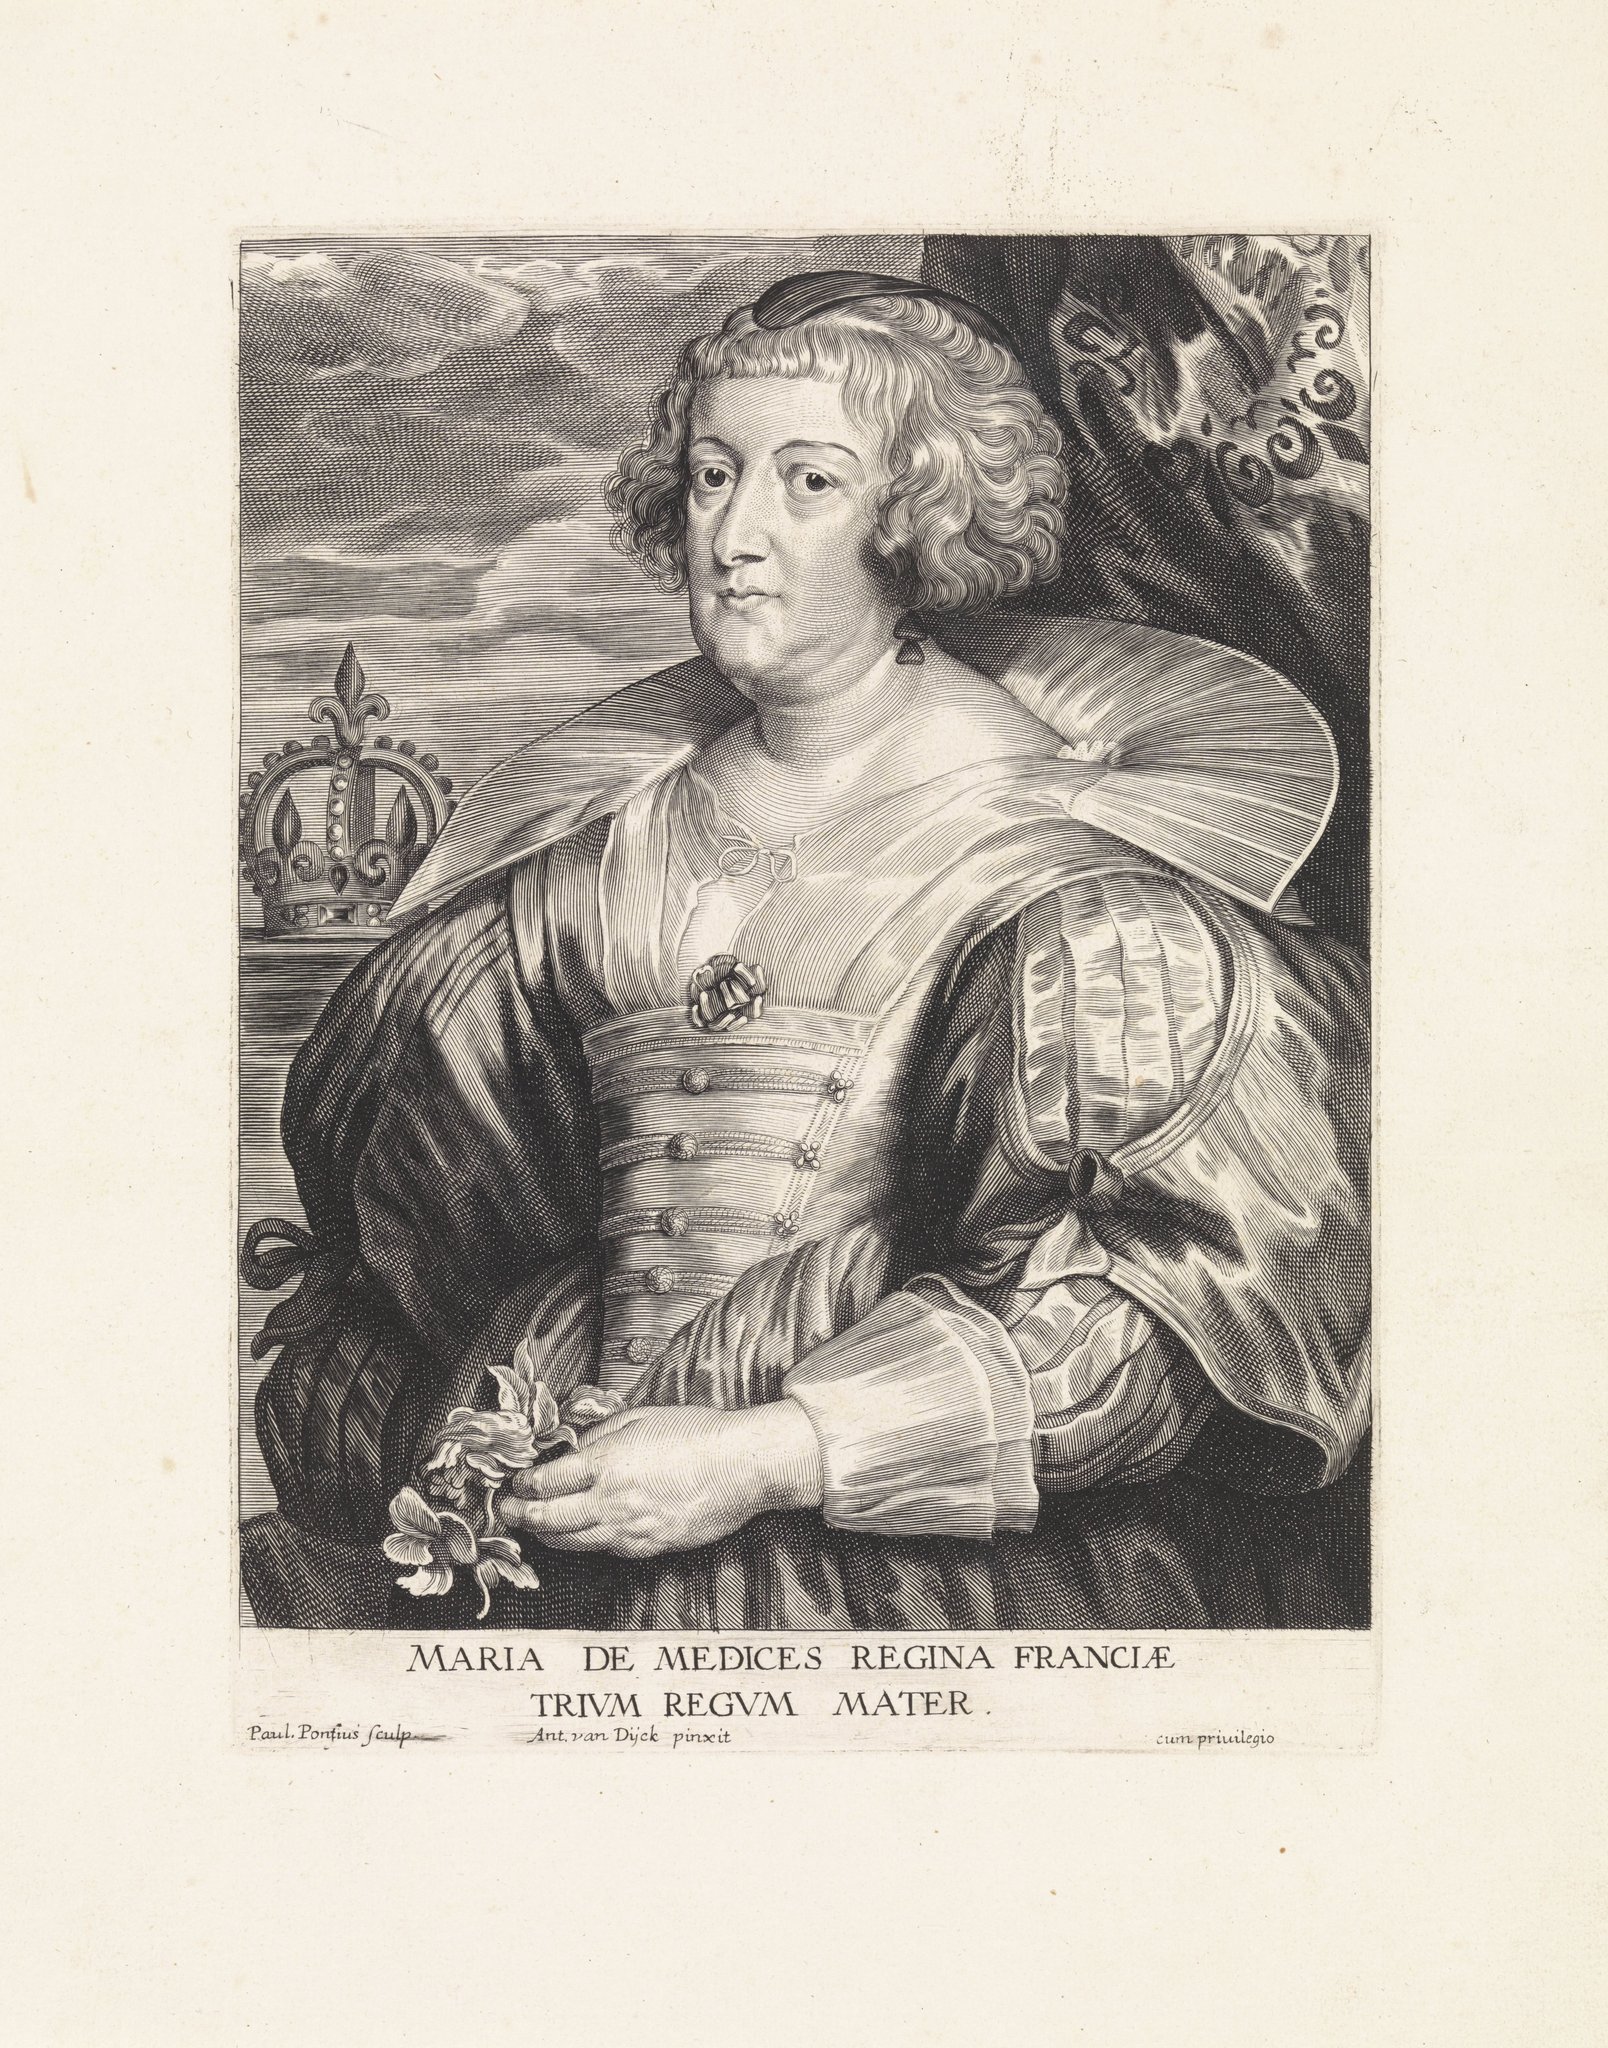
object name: print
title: Portret van Maria de' Medici, koningin van Frankrijk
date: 1616-1657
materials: paper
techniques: engraving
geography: antwerp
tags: cologne, print maker, maria de' medici, crown (symbol of sovereignty)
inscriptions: collector's mark: Lugt 2228, collector's mark: Lugt 2166, collector's mark: Lugt 2760